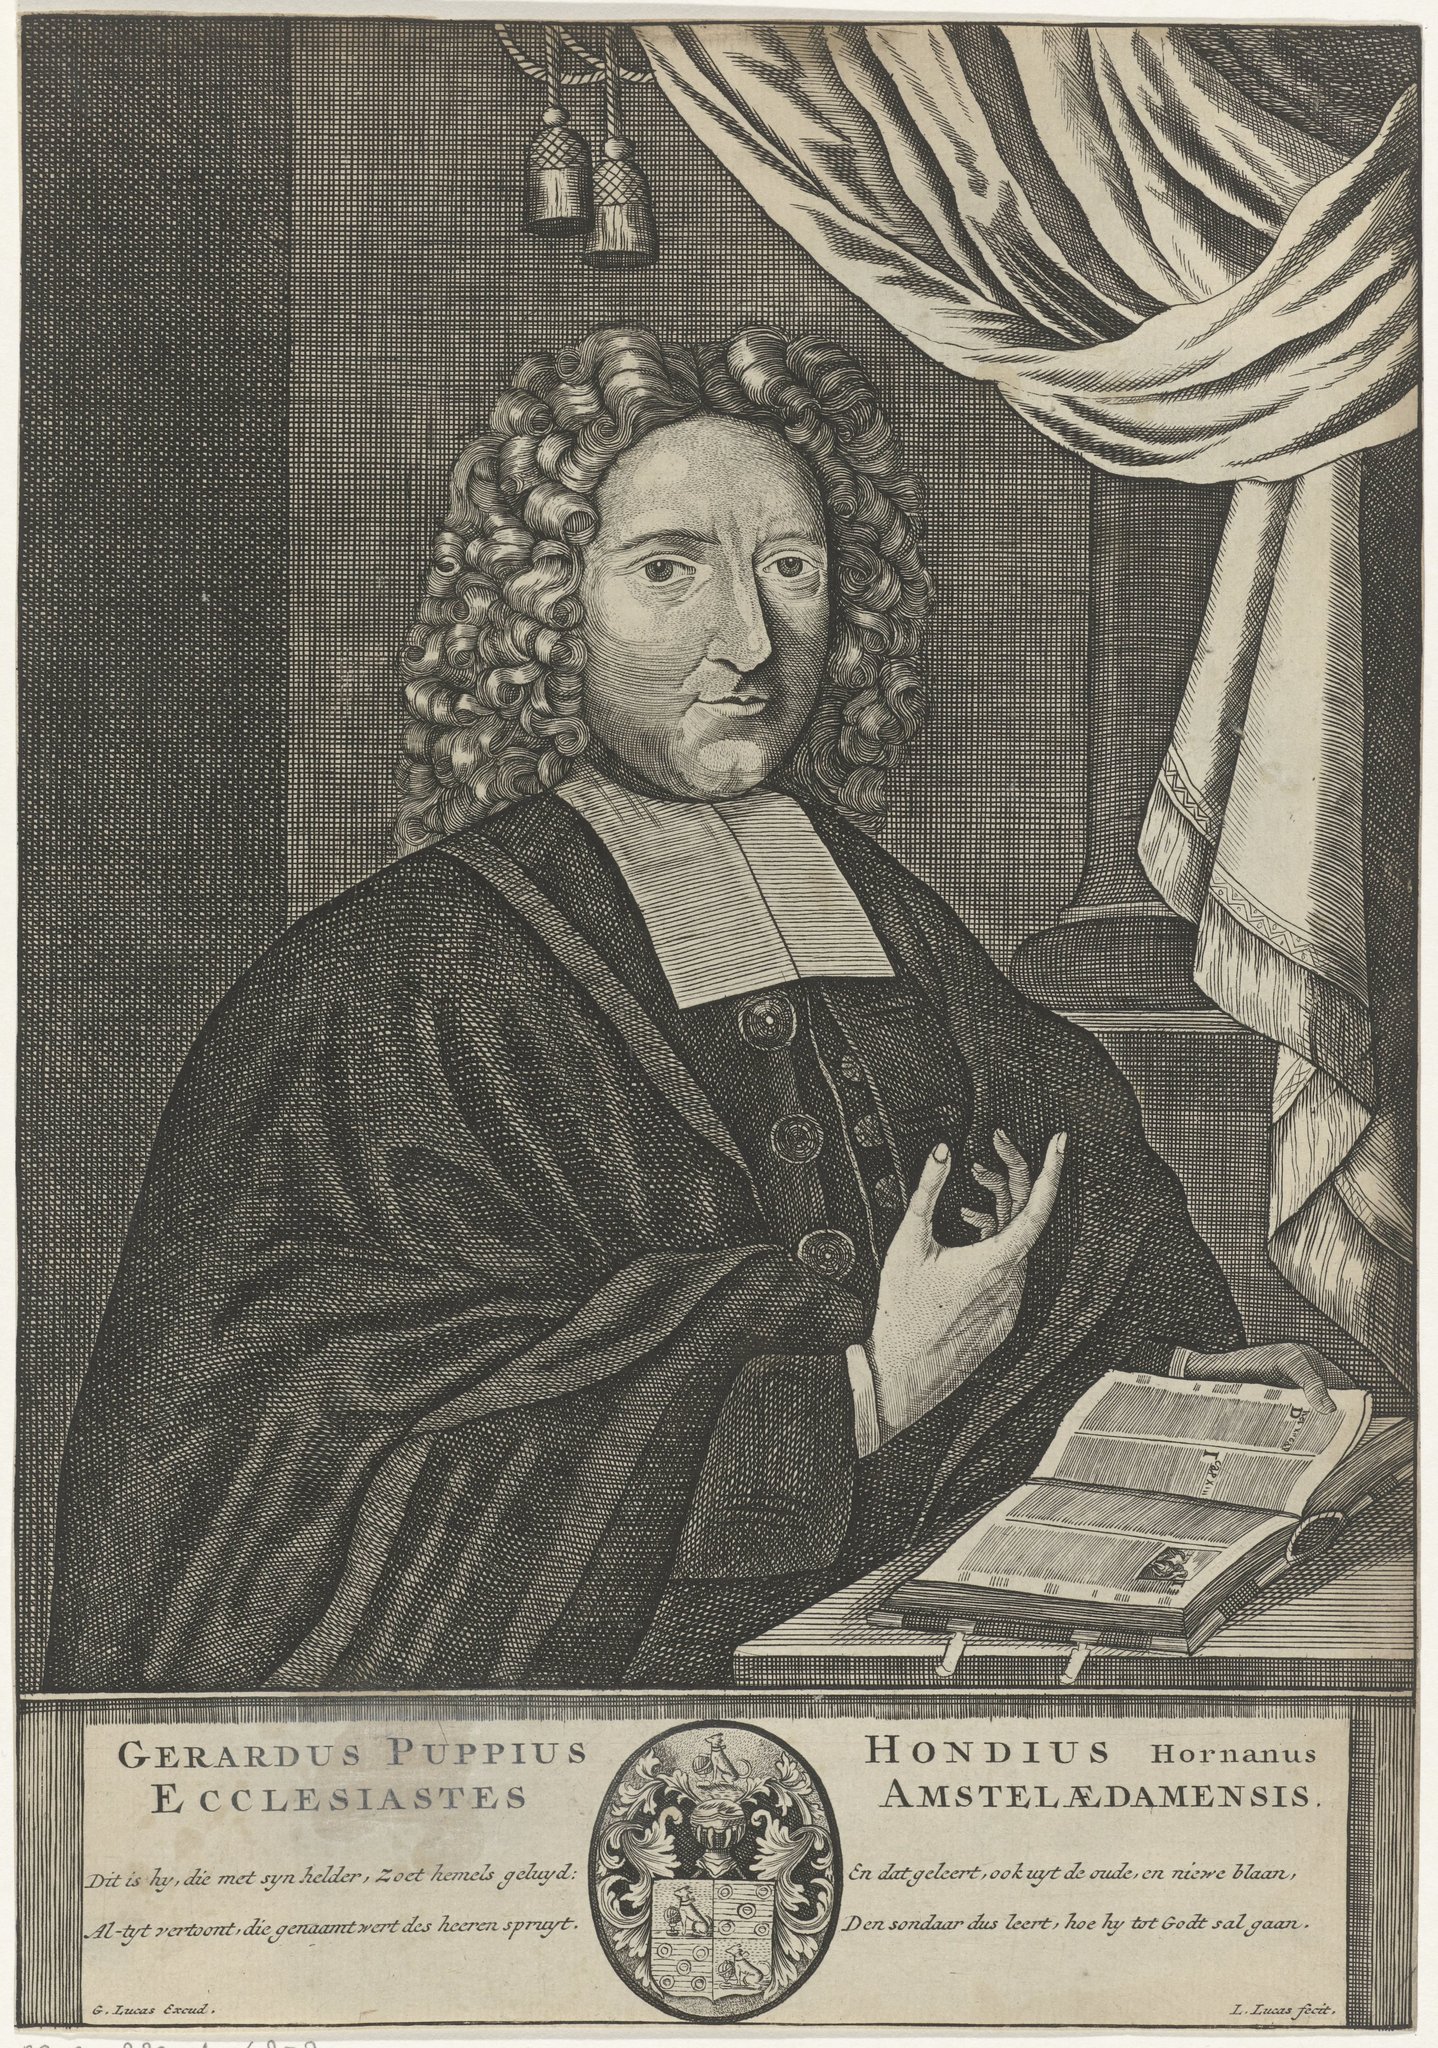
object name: print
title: Portret van Gerardus Puppius Hondius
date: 1650-1731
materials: paper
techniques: engraving, etching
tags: hoorn (north holland)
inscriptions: collector's mark: Lugt 2228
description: Portret van Gerardus Puppius Hondius, predikant te Amsterdam. Onder het portret het familiewapen van Hondius.